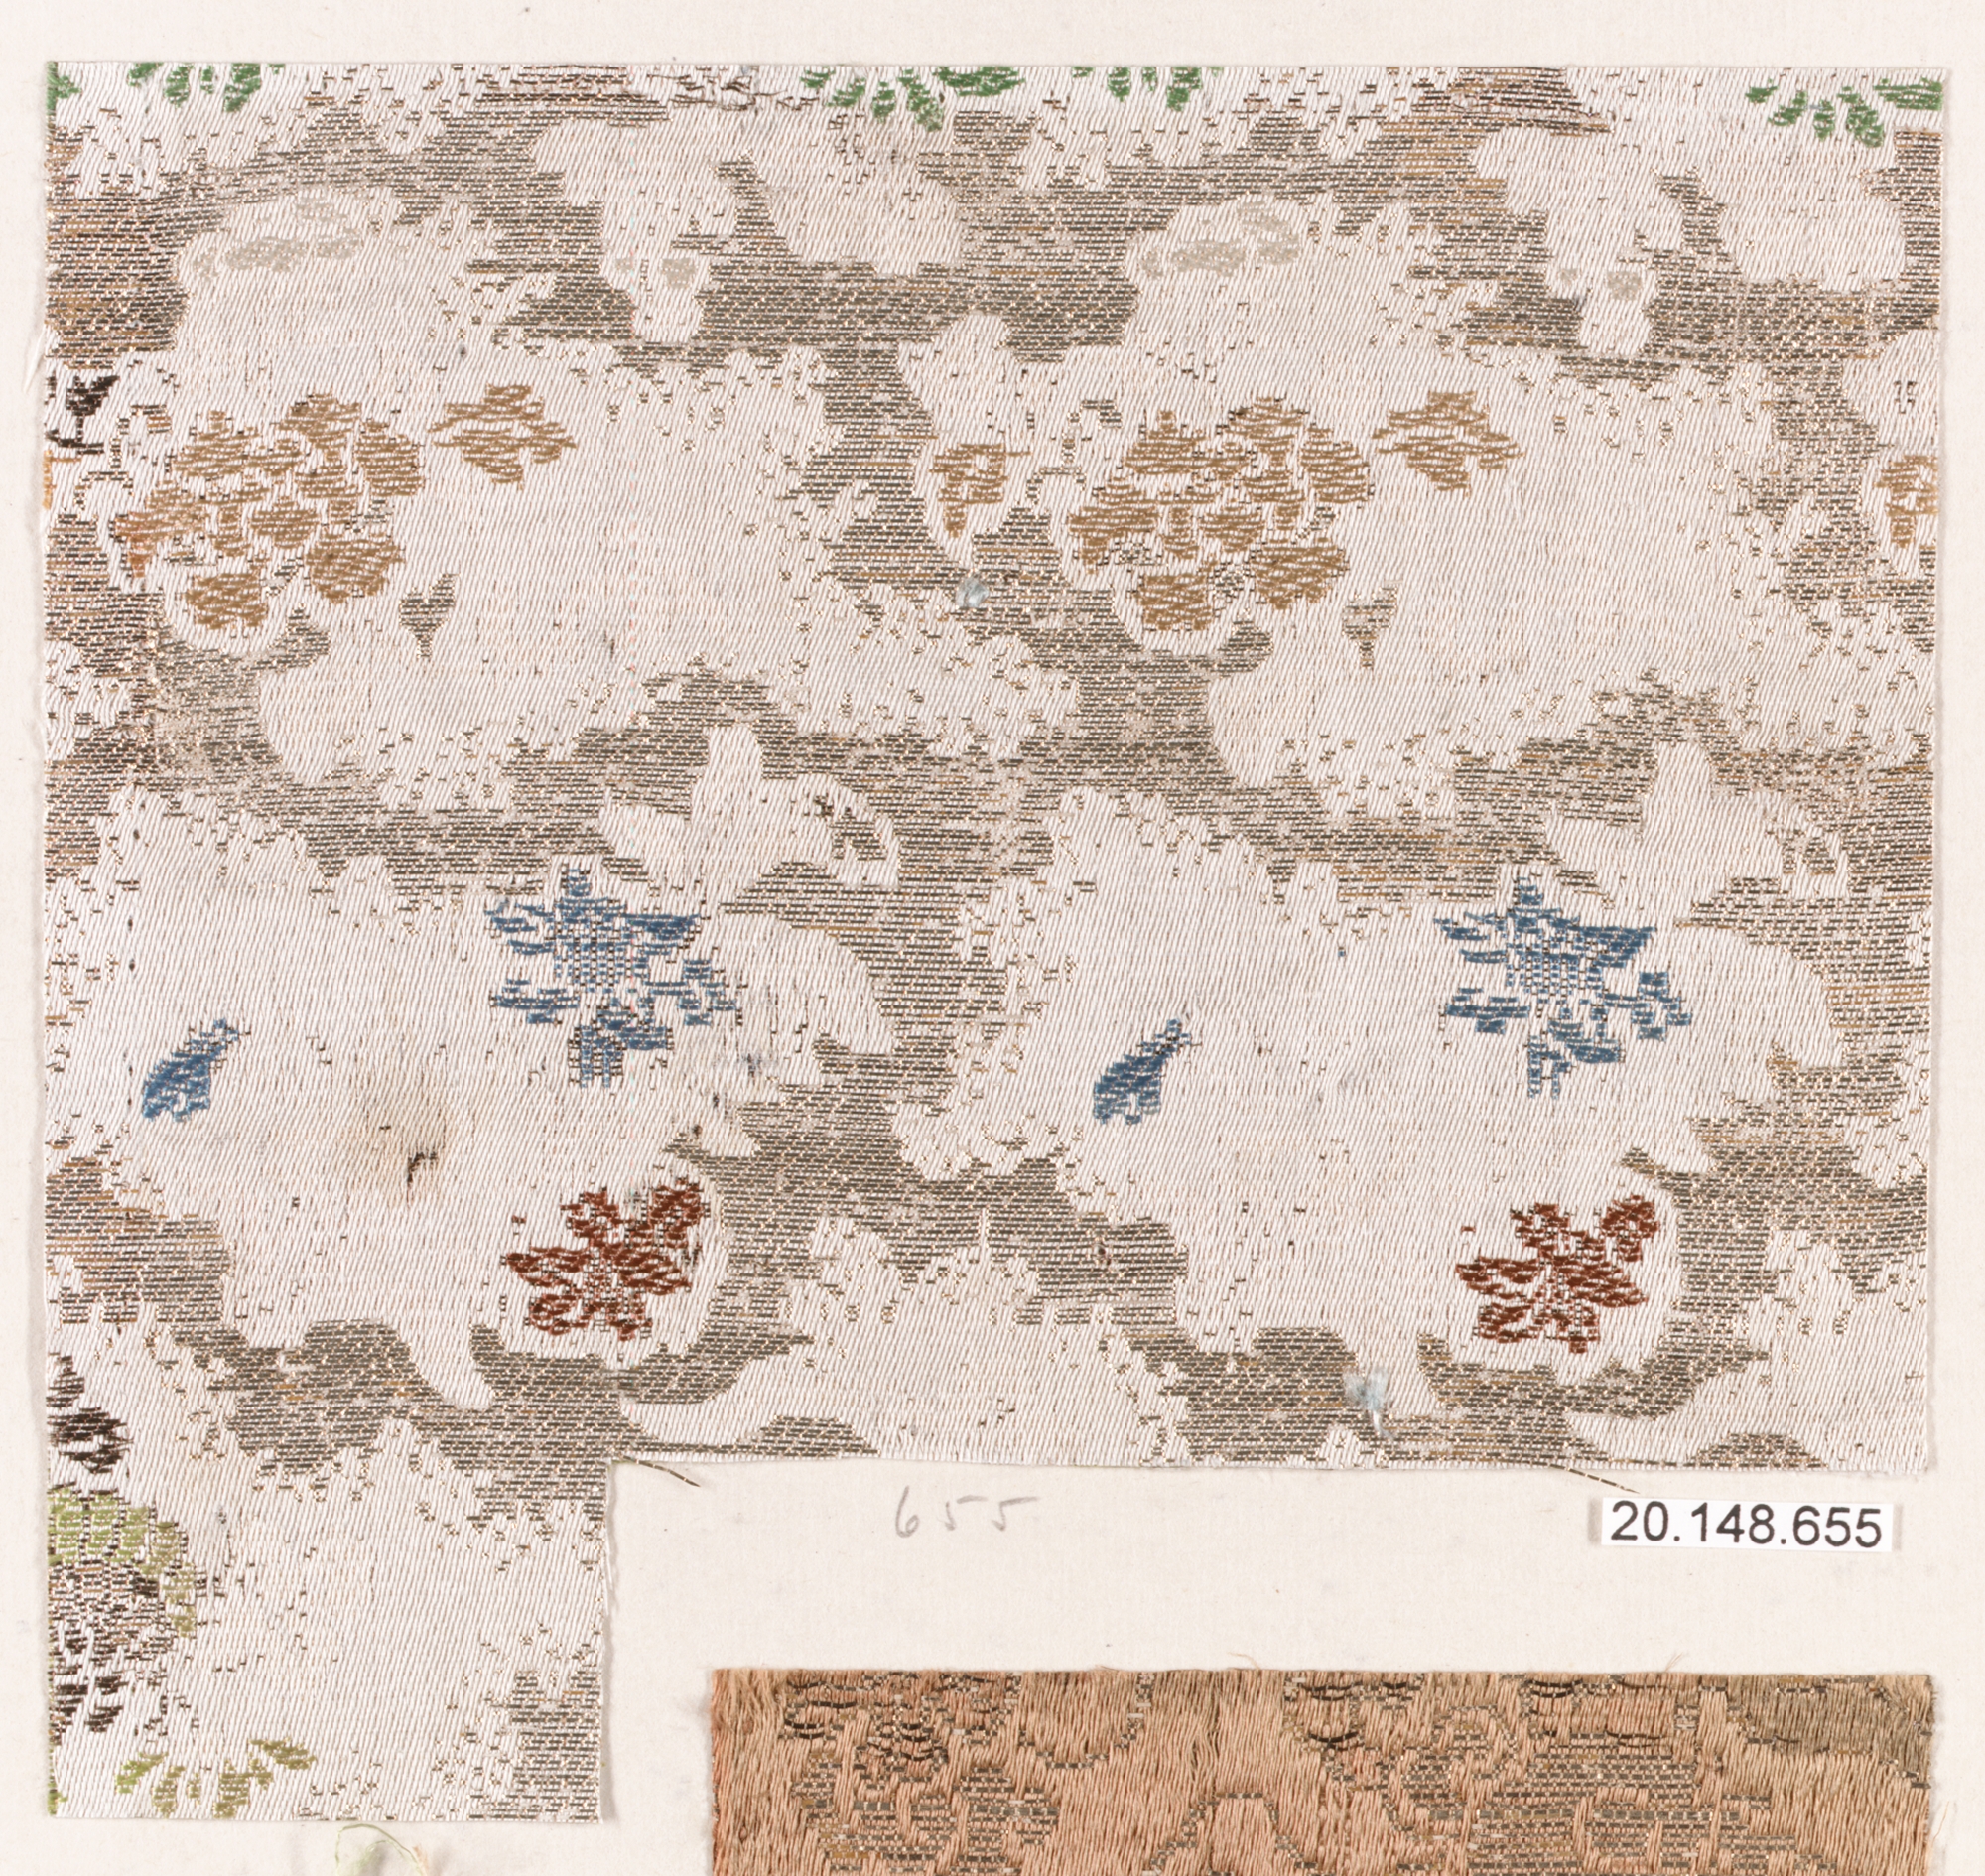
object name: piece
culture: japanese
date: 1601-1700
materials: silk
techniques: compound weave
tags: flowers